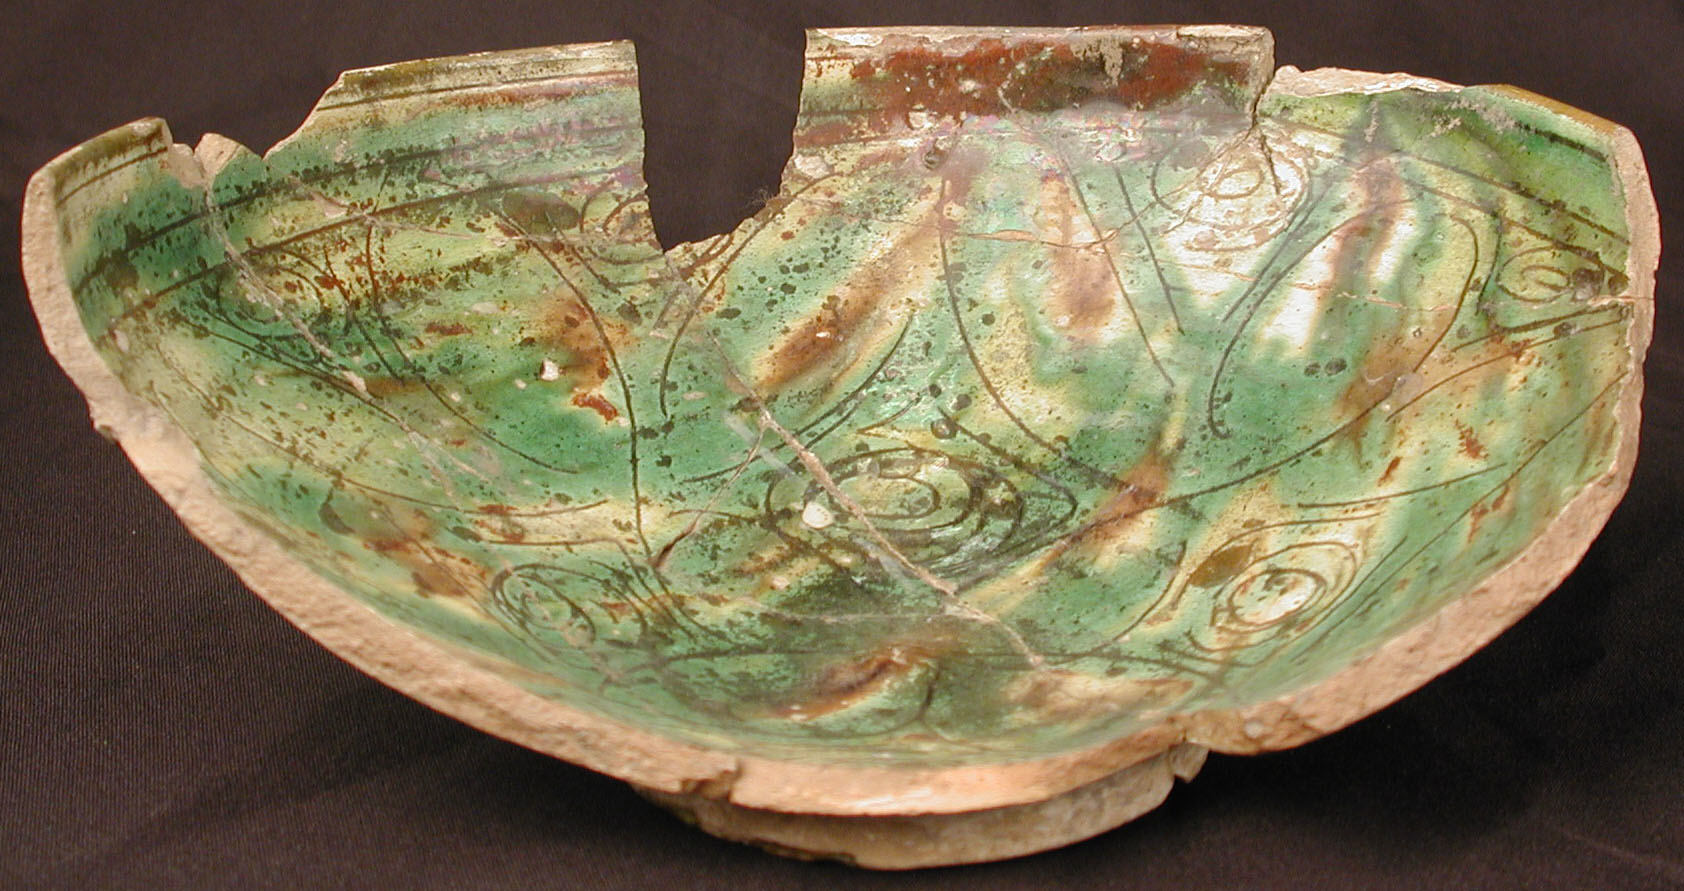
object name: bowl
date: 701-1200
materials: earthenware, glaze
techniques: incising, polychrome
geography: iran